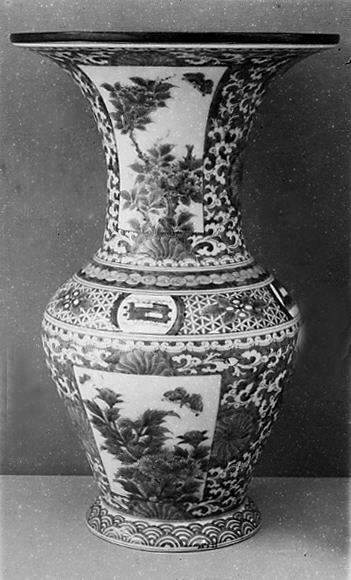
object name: vase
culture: japanese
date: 1830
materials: glaze, porcelain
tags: butterflies,leaves